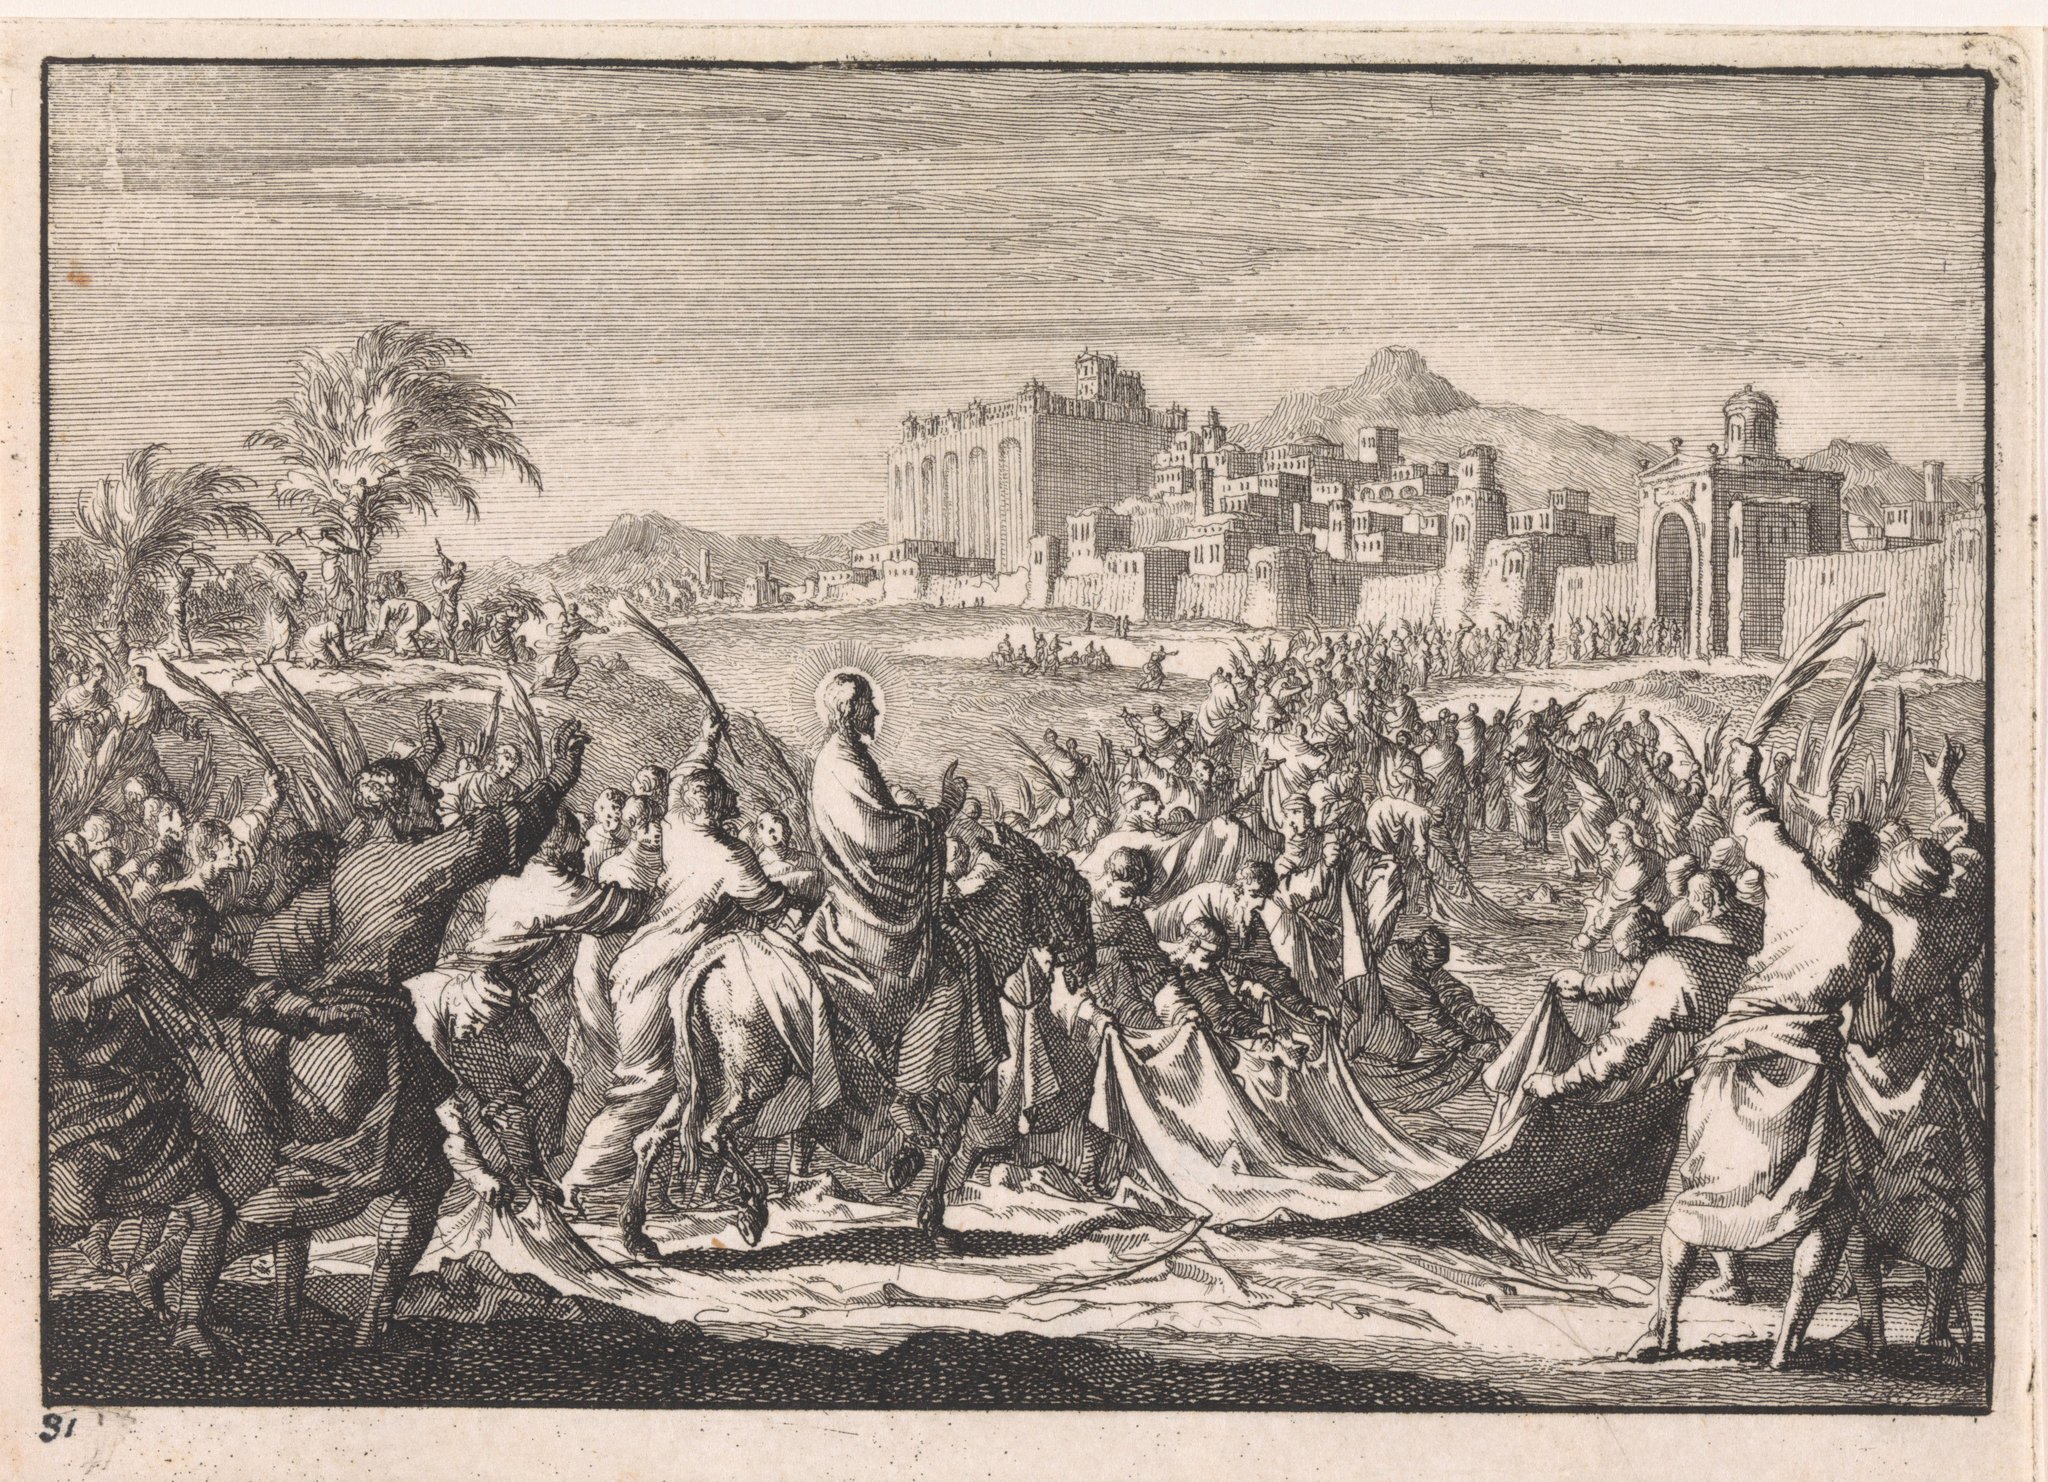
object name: print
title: Intocht in Jeruzalem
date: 1703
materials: paper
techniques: etching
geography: amsterdam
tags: entry into jerusalem: people spreading their clothes before christ on the ass, and waving palm branches (matthew 21:1-11, 21:14-16; mark 11:1-11; luke 19:28-40; john 12:12-19)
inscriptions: collector's mark: Lugt 2228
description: Proefdruk van een boekillustratie voor David Martin. Historie des Ouden en Nieuwen Testaments. Amsterdam, Pieter Mortier, 1703. Deel II. De boekillustraties voor de Mortierbijbel hebben verschillende staten en kopieën, waarbij de chronologische volgorde moeilijk te achterhalen valt. Als boekillustraties werden ze bovendien herhaaldelijk opnieuw gebruikt voor andere boekwerken.